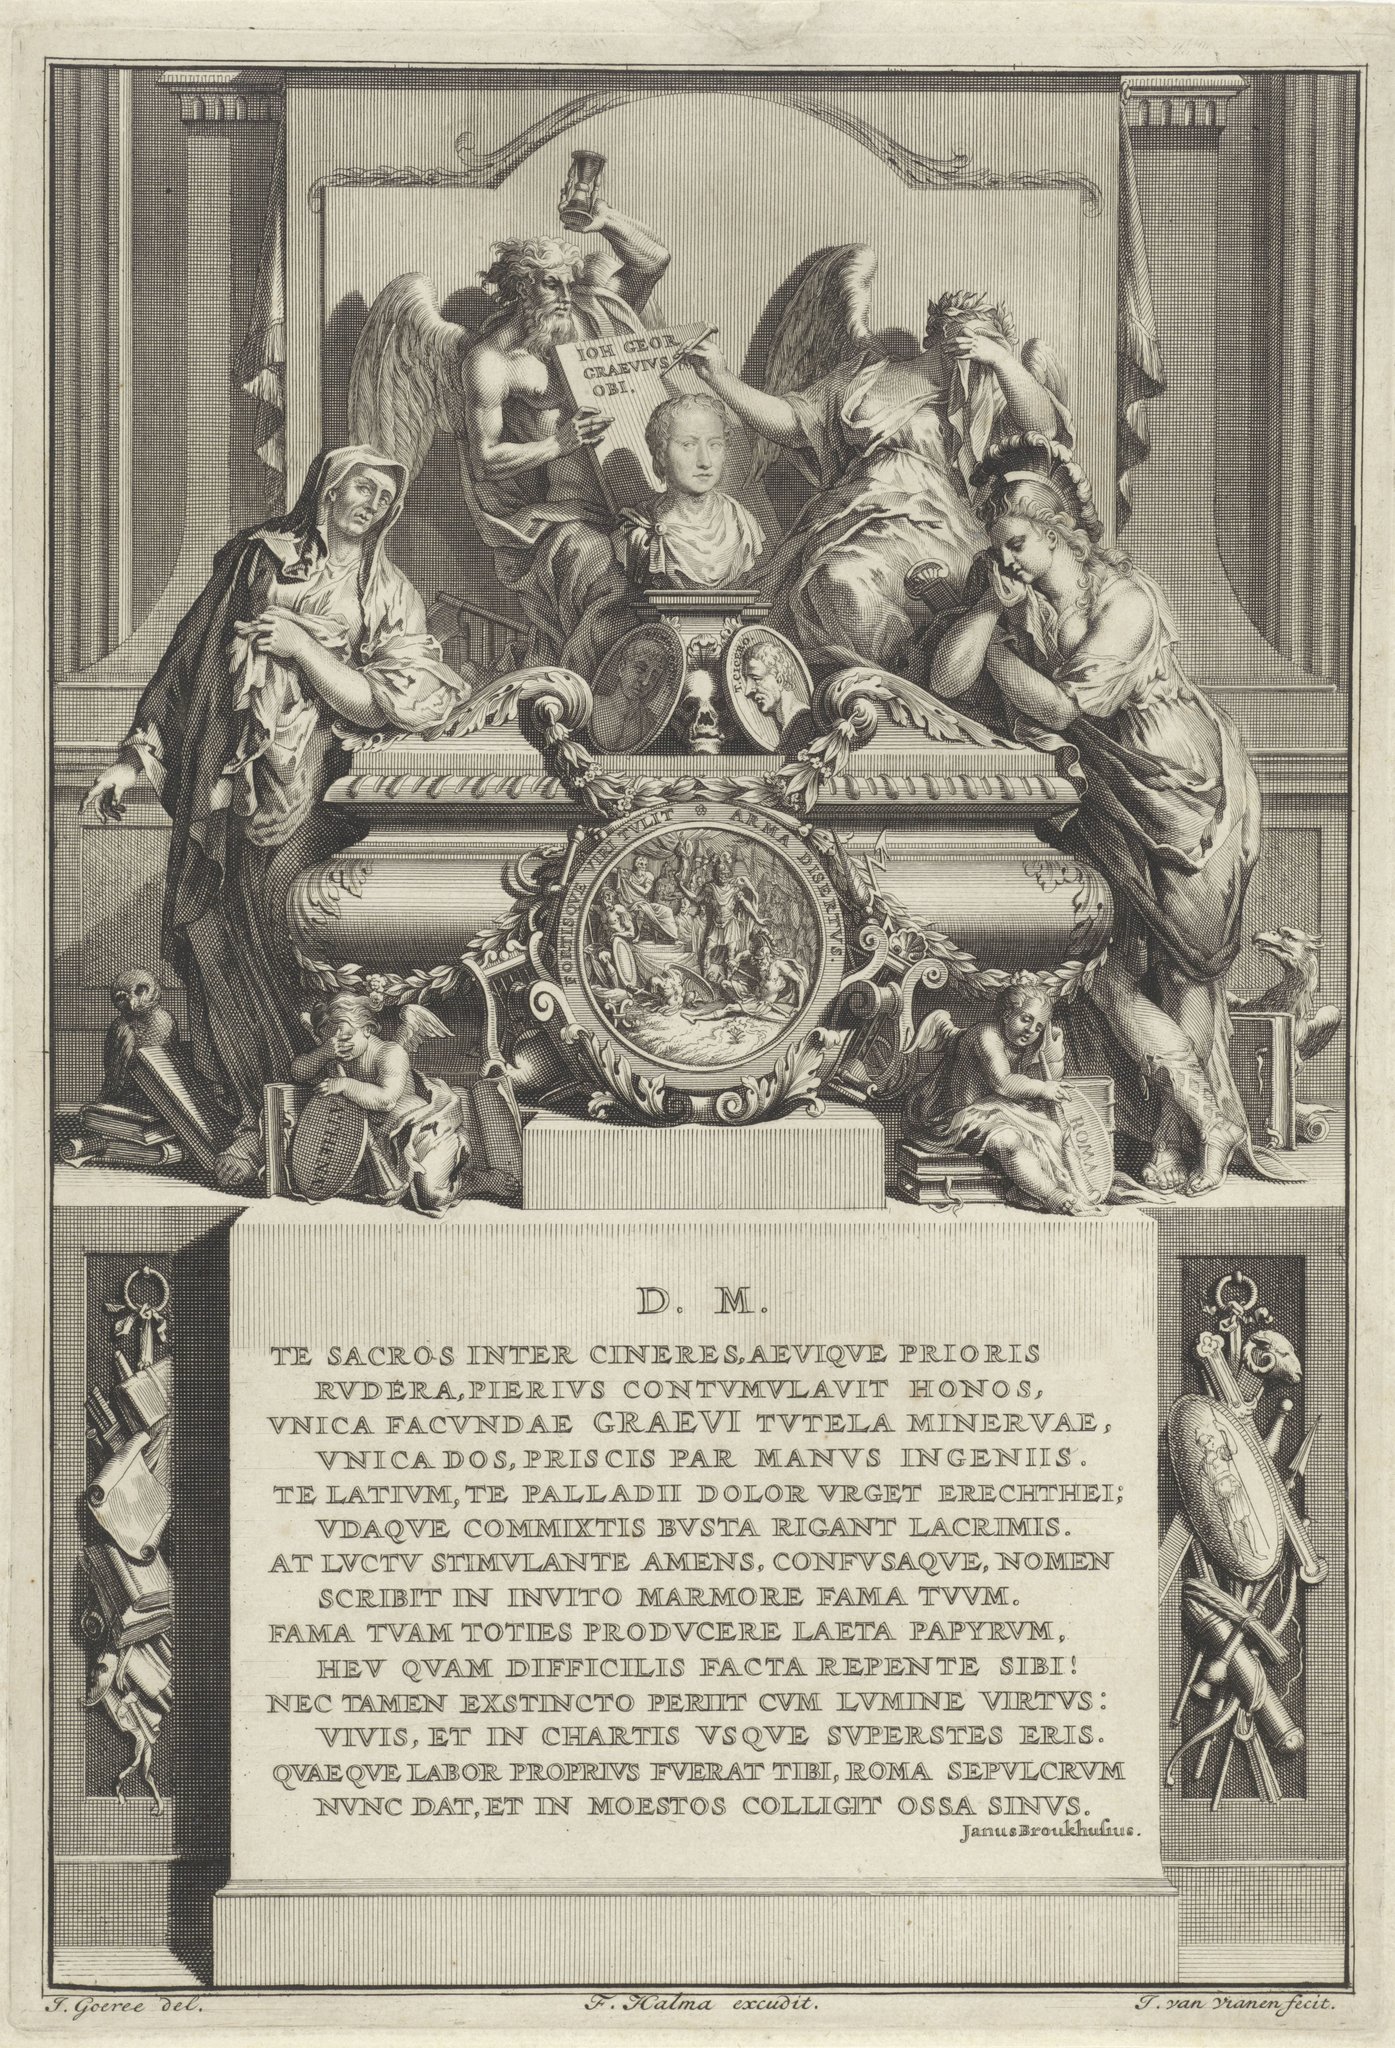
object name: print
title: Tombe van Johann Georg Graevius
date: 1703-1705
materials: paper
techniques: engraving, etching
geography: northern netherlands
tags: grave, tomb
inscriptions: collector's mark: Lugt 2228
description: Tombe met het borstbeeld van de schrijver en geleerde Johann Georg Graevius, geflankeerd door verschillende allegorische figuren.